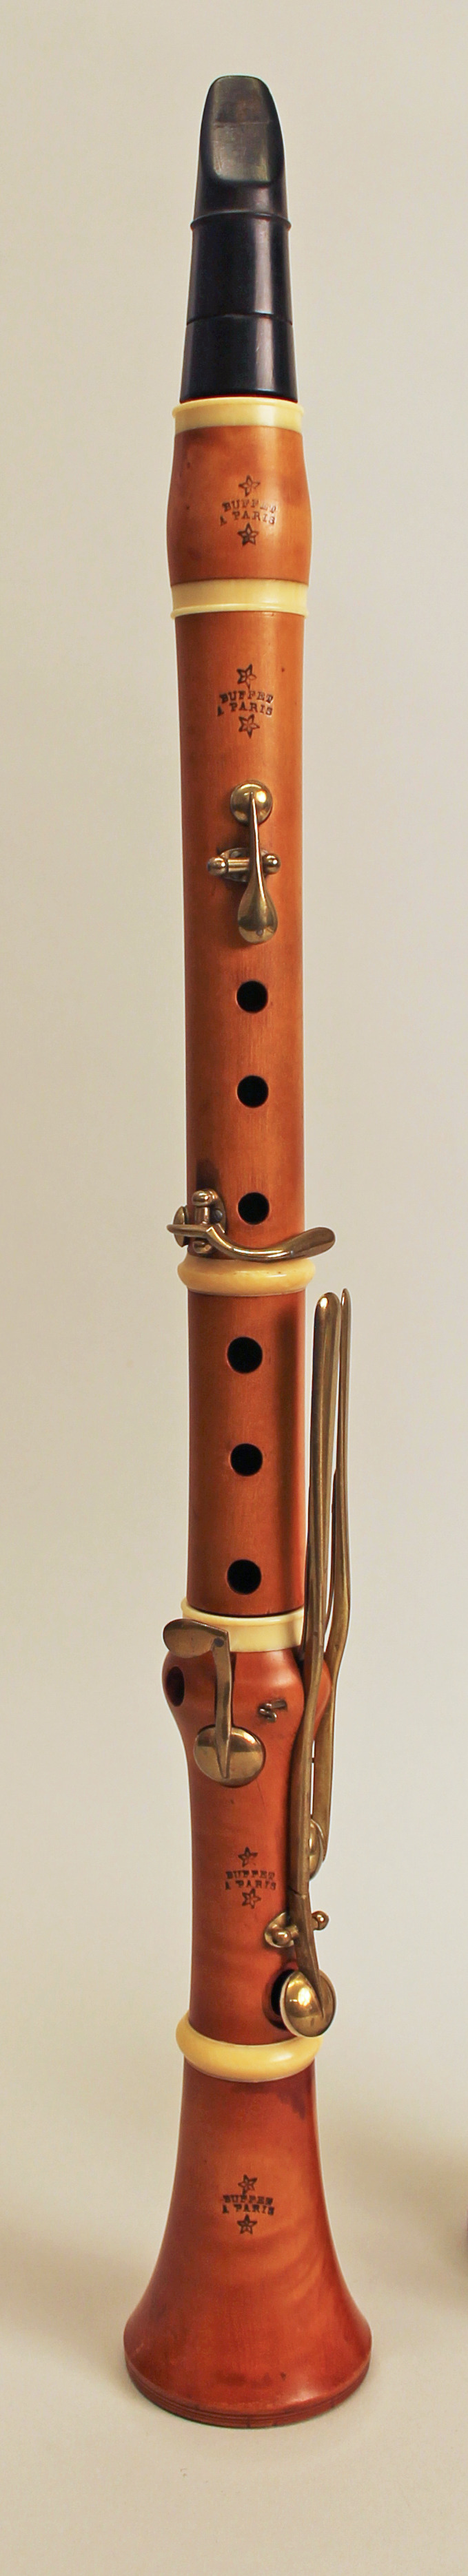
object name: clarinet in e flat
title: Clarinet in E-flat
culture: french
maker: denis buffet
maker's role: maker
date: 1825-1830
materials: wood, brass, ivory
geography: france